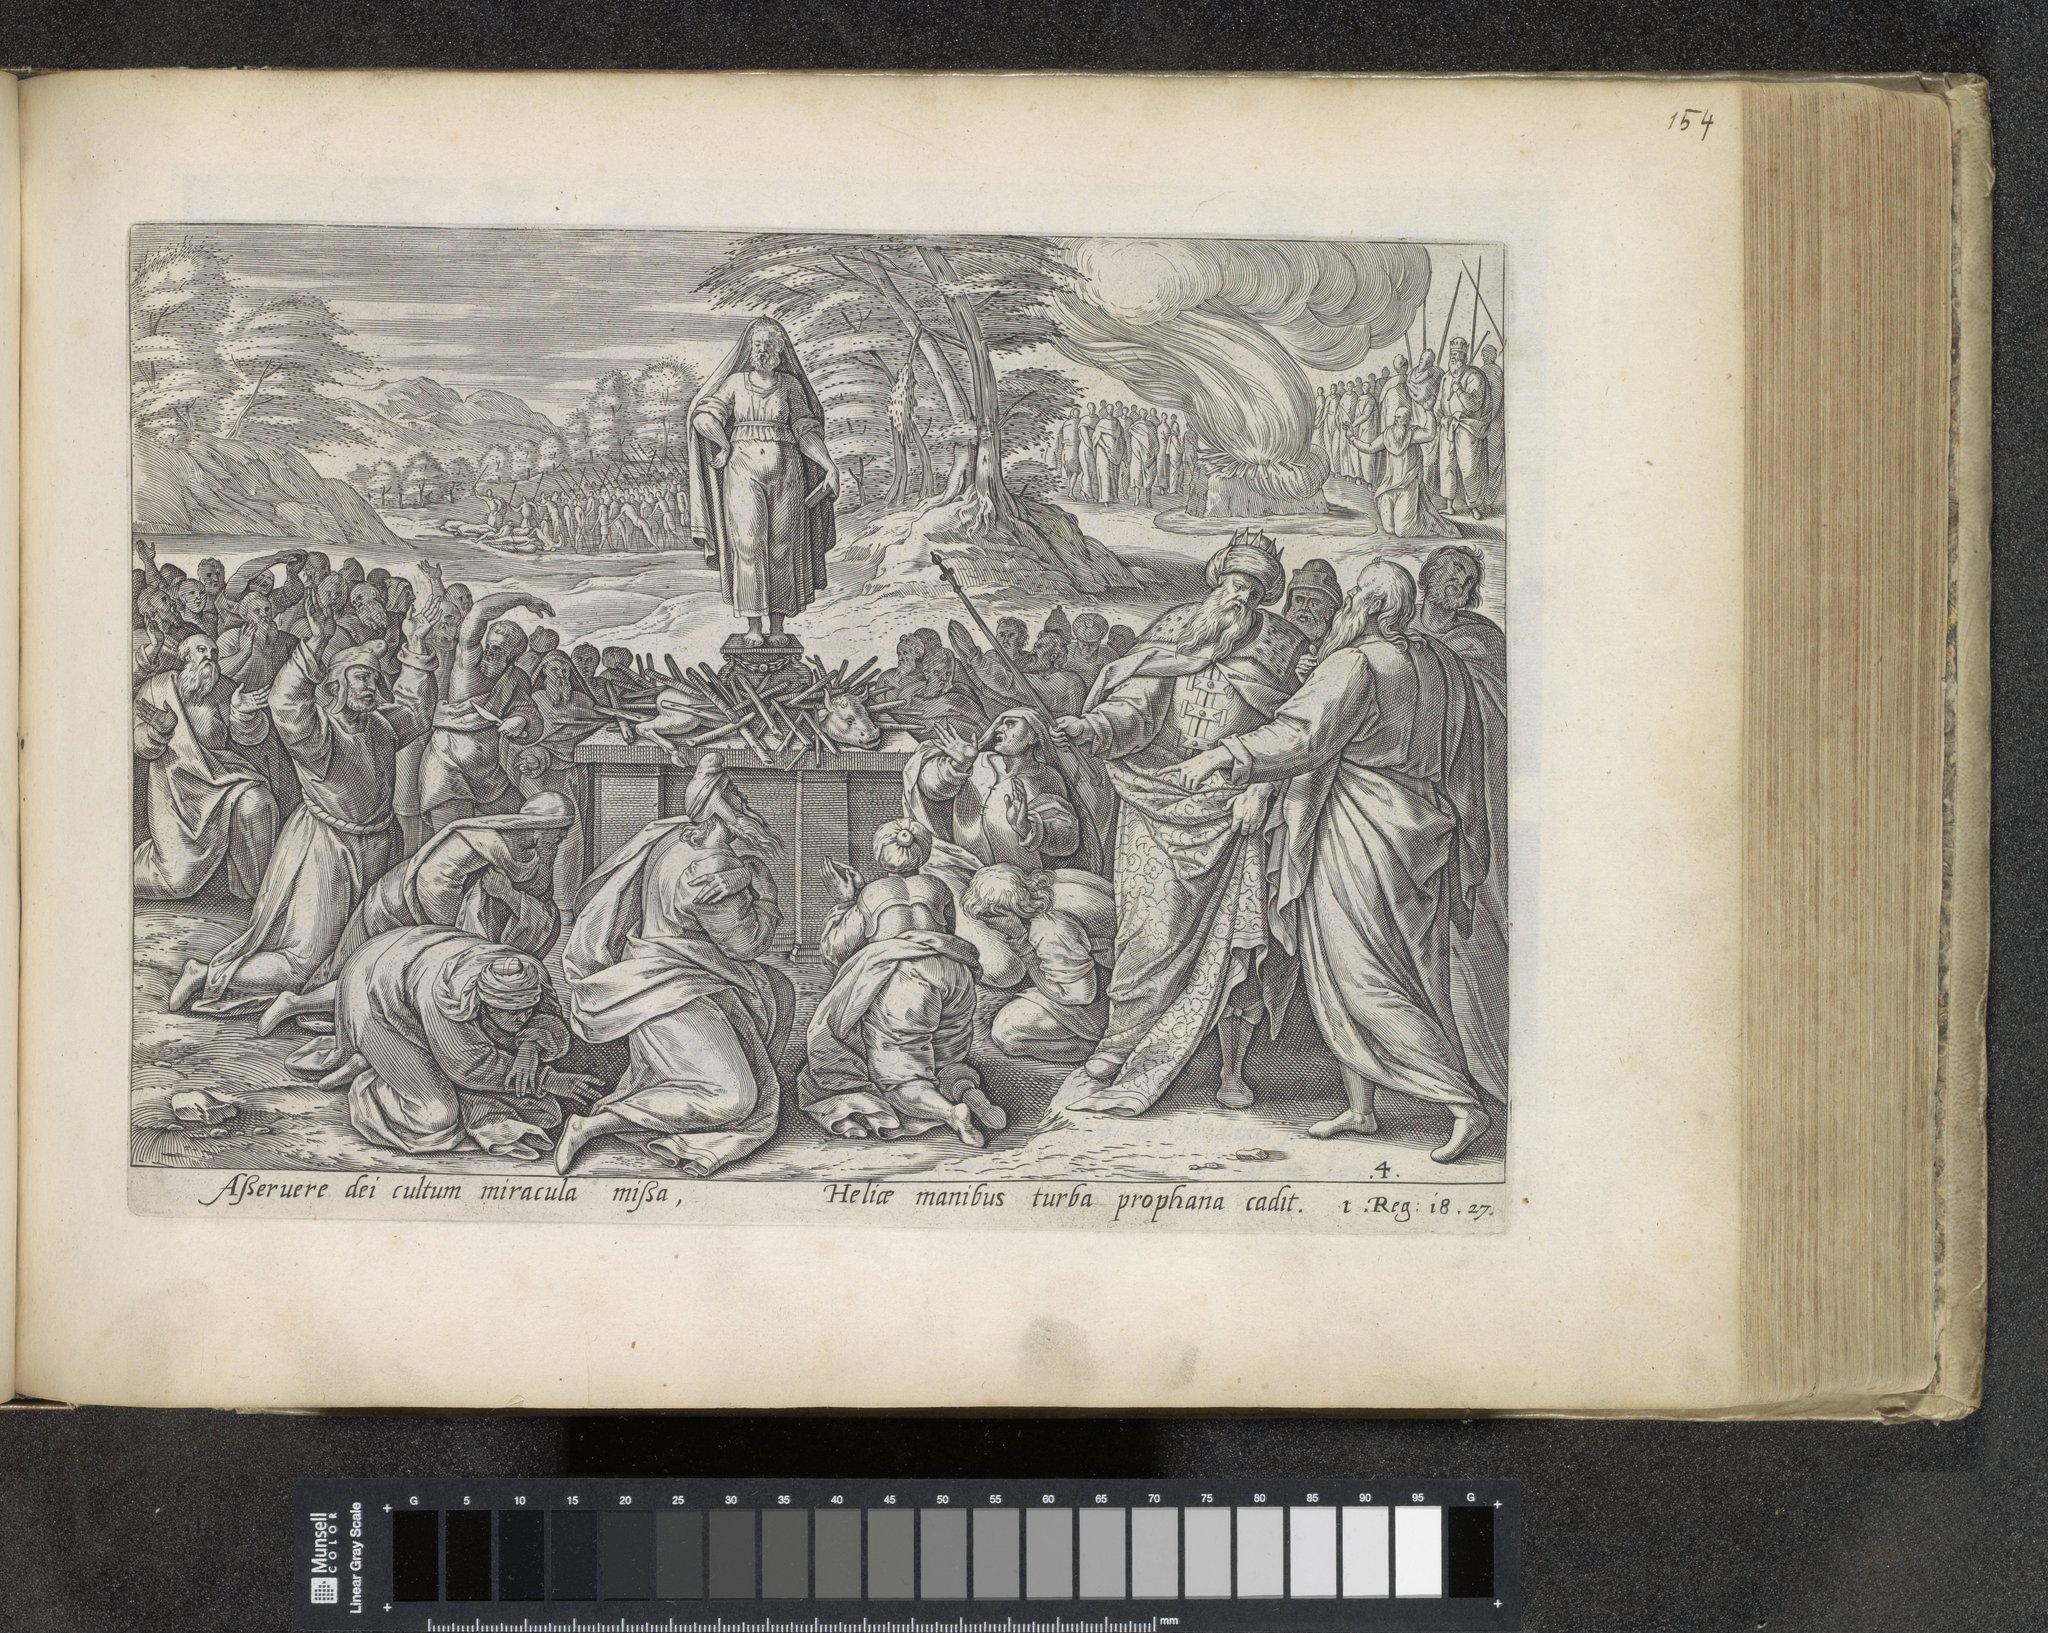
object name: print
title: Theatrum Biblicum Hoc Est Historiae Sacrae Veteris et Novi Testamenti Tabulis Aeneis Expressae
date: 1579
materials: paper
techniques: engraving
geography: amsterdam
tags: an altar is prepared by the baal-worshippers and a bull is laid upon it; all the priests' cries, wild dances and self-mutilations are in vain (sacrifice on mount carmel), as elijah prays, god sends fire which burns up not only his sacrifice but also the altar itself; the people fall prostrate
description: De Baälpriesters schreeuwen en dansen rond hun altaar, roepen de god Baäl aan en bidden hem om vuur voor het brandoffer. Bij het altaar staat koning Achab. Op de achtergrond rechts bidt Elia tot zijn God bij zijn brandoffer dat wordt ontstoken door vuur uit de hemel. Op de achtergrond links worden de profeten van Baäl na dit voorval ter dood gebracht. Onder de voorstelling een verwijzing in het Latijn naar de Bijbeltekst in 1 Kon. 18:27. Deze prent maakt deel uit van een album.